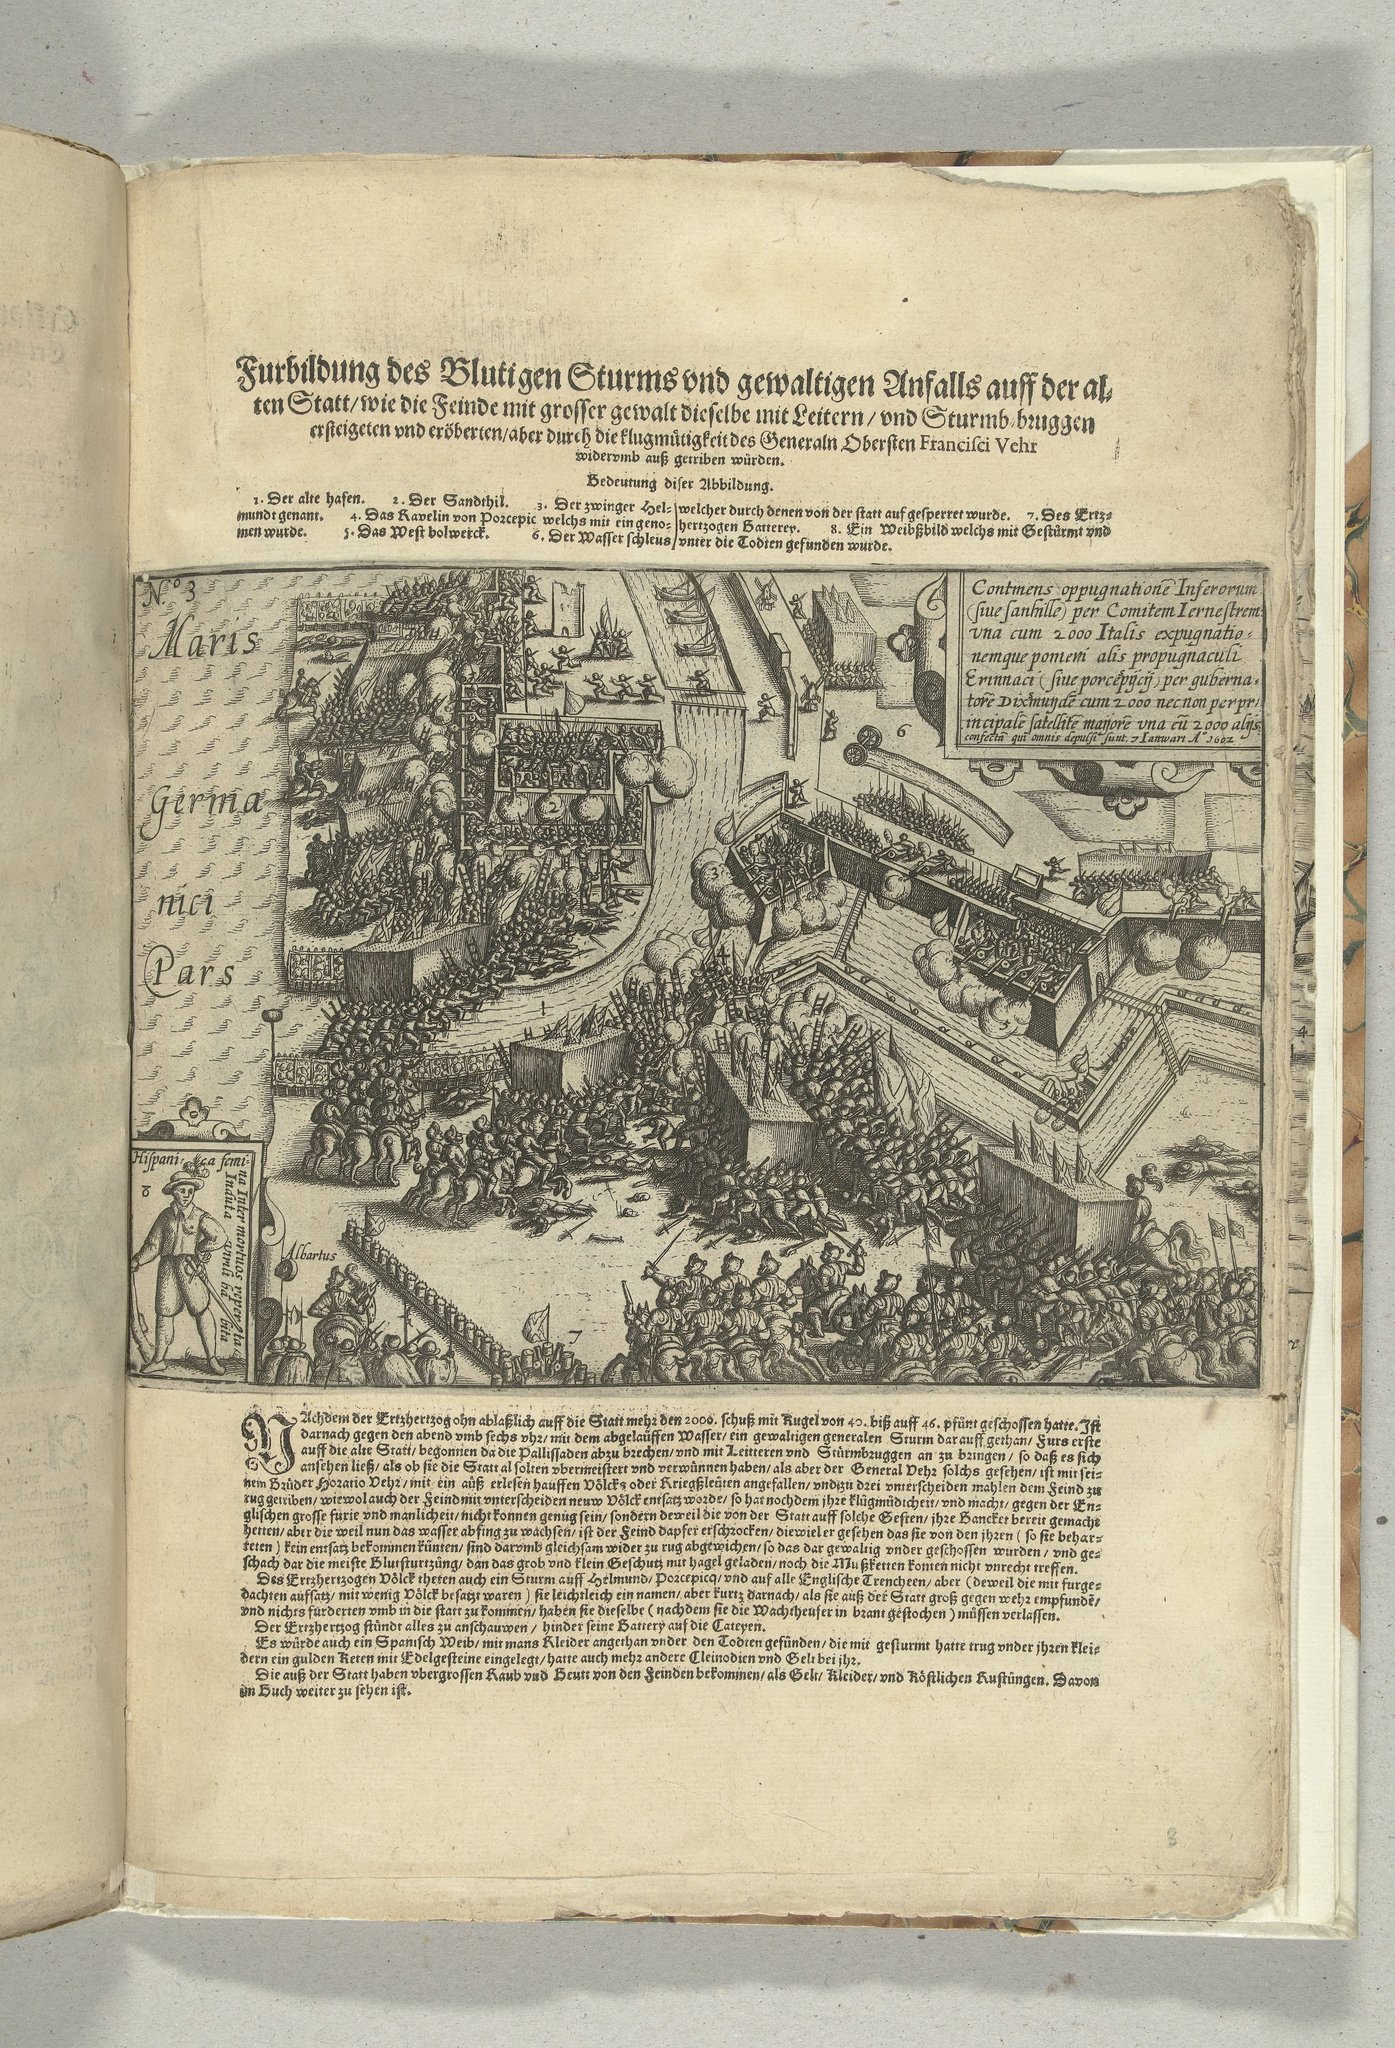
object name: print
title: Furbildung des Blutigen Sturms und gewaltigen Anfalls auff der alten Statt / wie die Feinde mit grosser gewalt dieselbe mit Leitern / und Sturmb-bruggen ersteigeten und eröberten / aber durch die flugmütigkeit des Generaln Obersten Francisci Vehr widerumb auss getriben würden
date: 1602-1604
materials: paper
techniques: etching, letterpress printing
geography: low countries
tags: brussels, albrecht aartshertog van oostenrijk, siege, position war, battle (+ land forces)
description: Zware bestorming van de verdedigingswerken van Oostende door de Spaanse troepen onder Albrecht, 7 januari 1602. Linksonder een inzet met een een plaatje van een vrouwelijke Spaanse soldaat die bij de gevechten betrokken was, rechtsboven een cartouche met opschrift in het Latijn. Boven de prent de titel met verklaring van de cijfers, onderaan een beschrijving van de gebeurtenissen, in het Duits. Onderdeel van de illustraties bij een journaal van het beleg van Oostende 1601-1604.